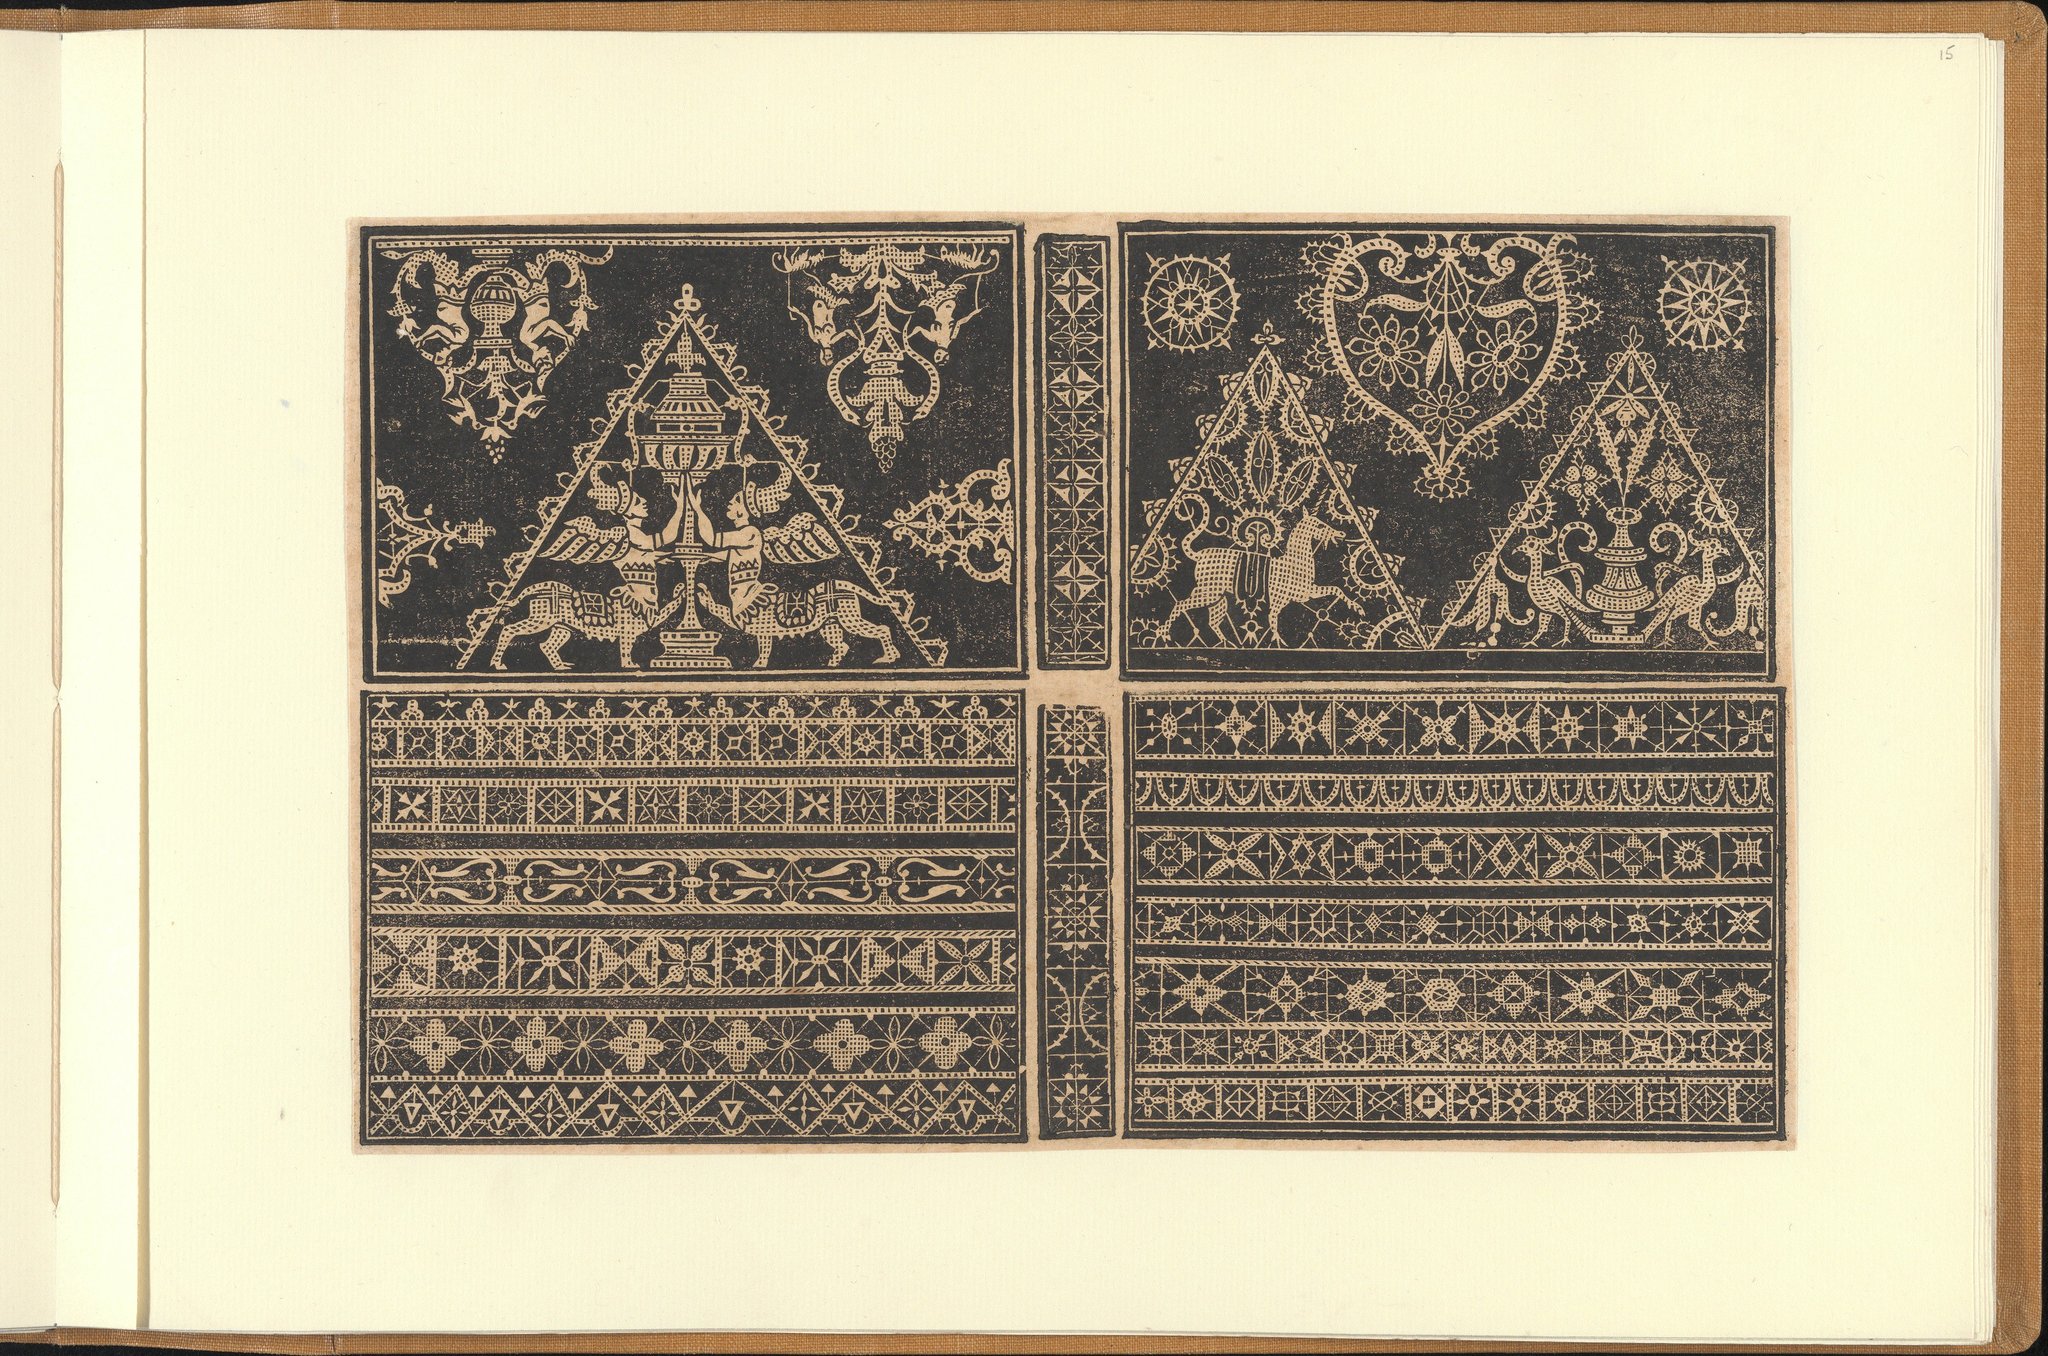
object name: album print ornament architecture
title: Schon newes Modelbuch...Page 15(r)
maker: sigismundus latomus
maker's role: designer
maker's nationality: german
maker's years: 1599-1632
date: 1617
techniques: woodcut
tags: animals,birds,centaurs